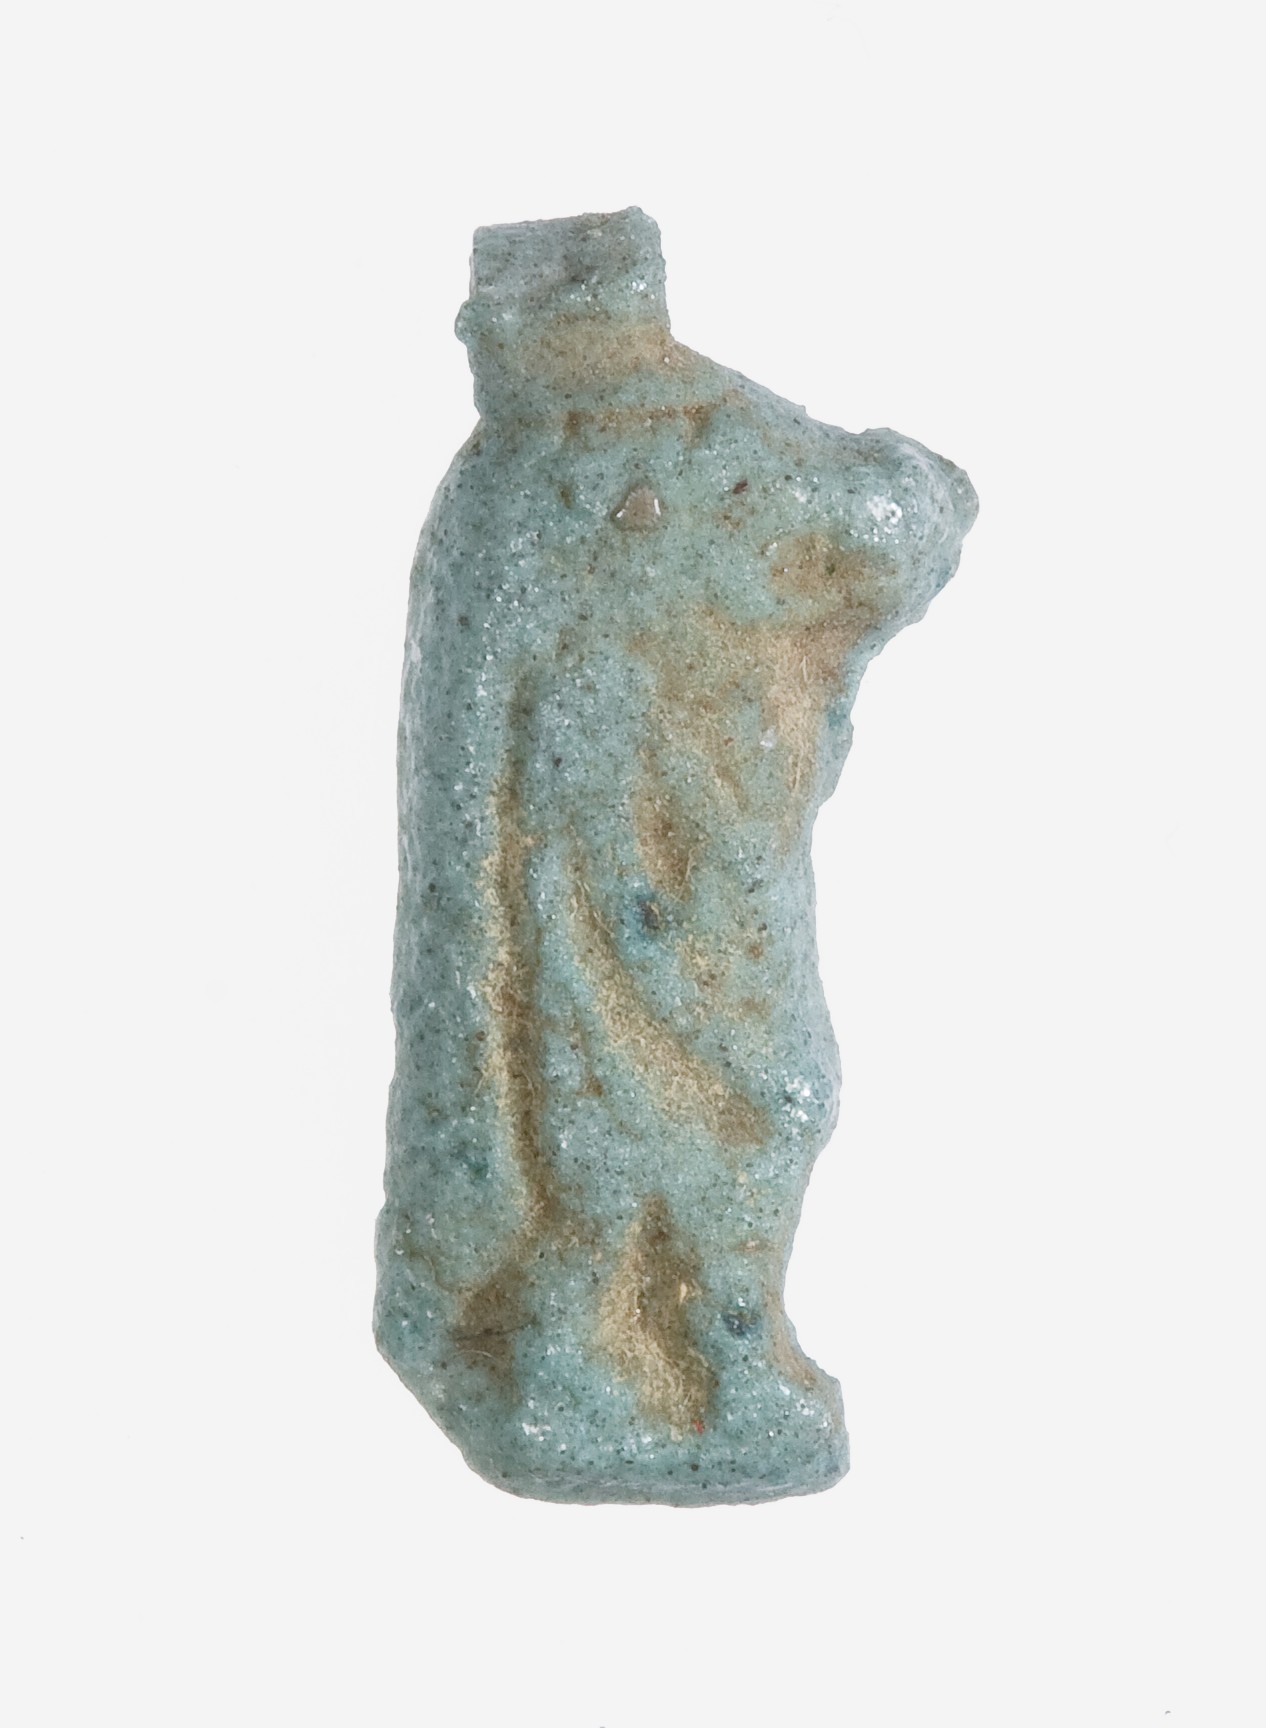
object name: amulet, taweret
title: Amulet: Taweret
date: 1390-1352 BCE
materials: faience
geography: egypt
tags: taweret